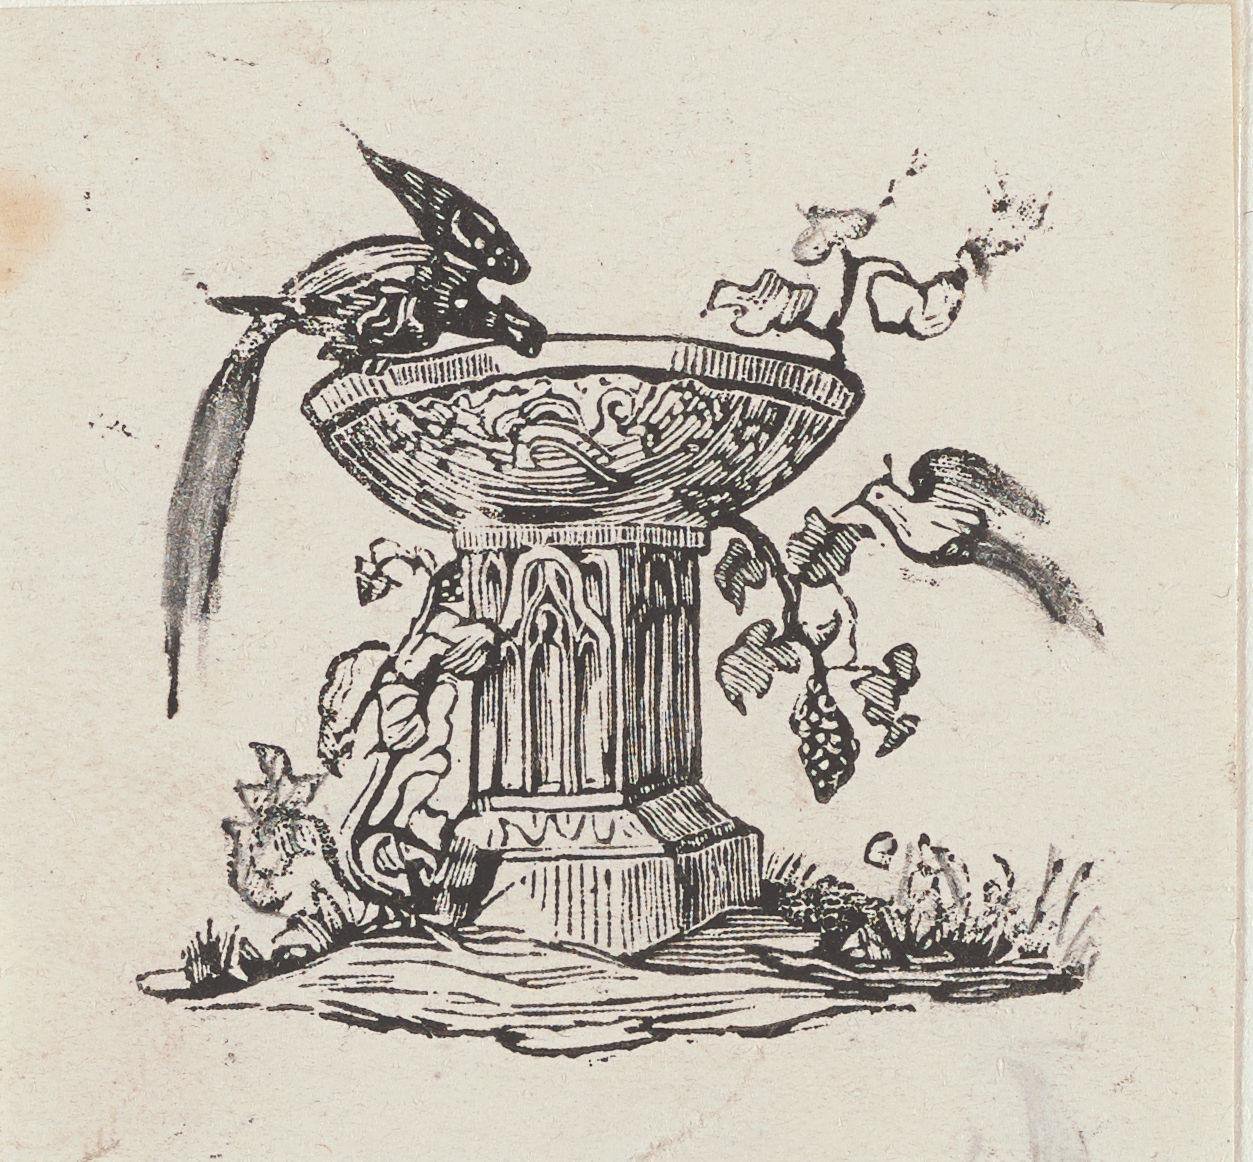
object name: print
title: Vogels bij een vogelbad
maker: isaac weissenbruch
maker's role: print maker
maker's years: 1826-1912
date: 1836-1912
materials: paper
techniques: engraving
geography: netherlands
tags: birds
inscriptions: collector's mark: Lugt 2228